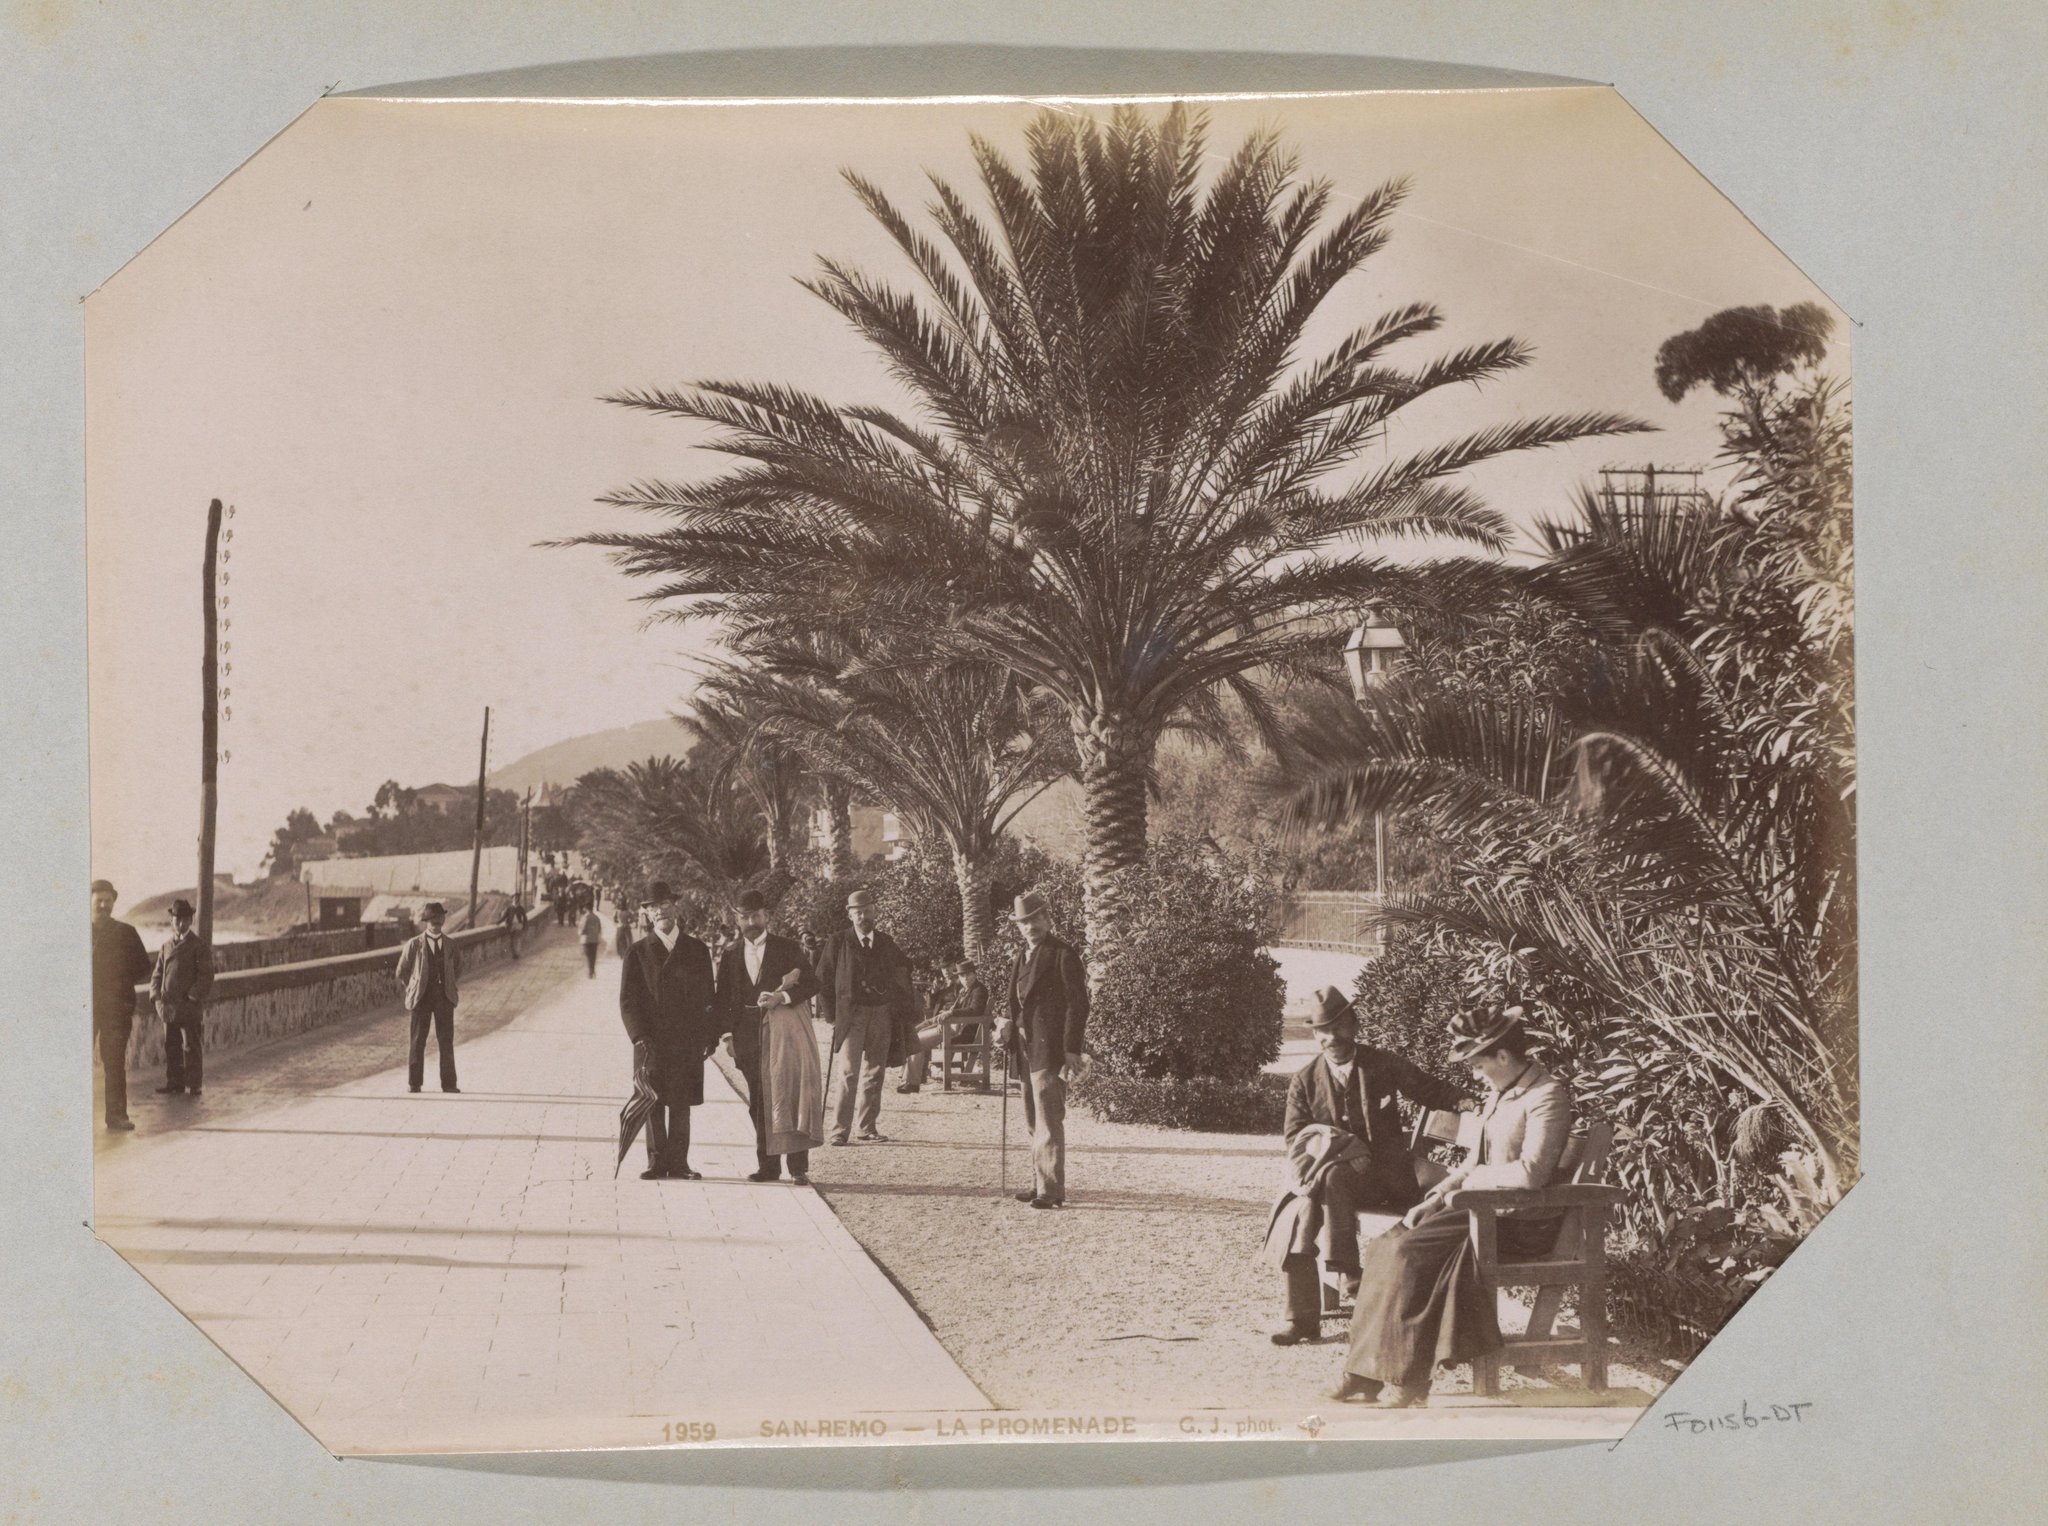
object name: album leaf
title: Mannen met hoeden op de promenade van San Remo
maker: jean gilletta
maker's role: fotograaf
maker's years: 1856-1933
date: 1880-1900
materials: photographic support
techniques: albumen print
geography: san remo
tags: avenue, boulevard, promenade, esplanade (+ city(-scape) with figures, staffage)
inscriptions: inscription: ‘1959 San-Remo - La promenade G.J. Phot.’